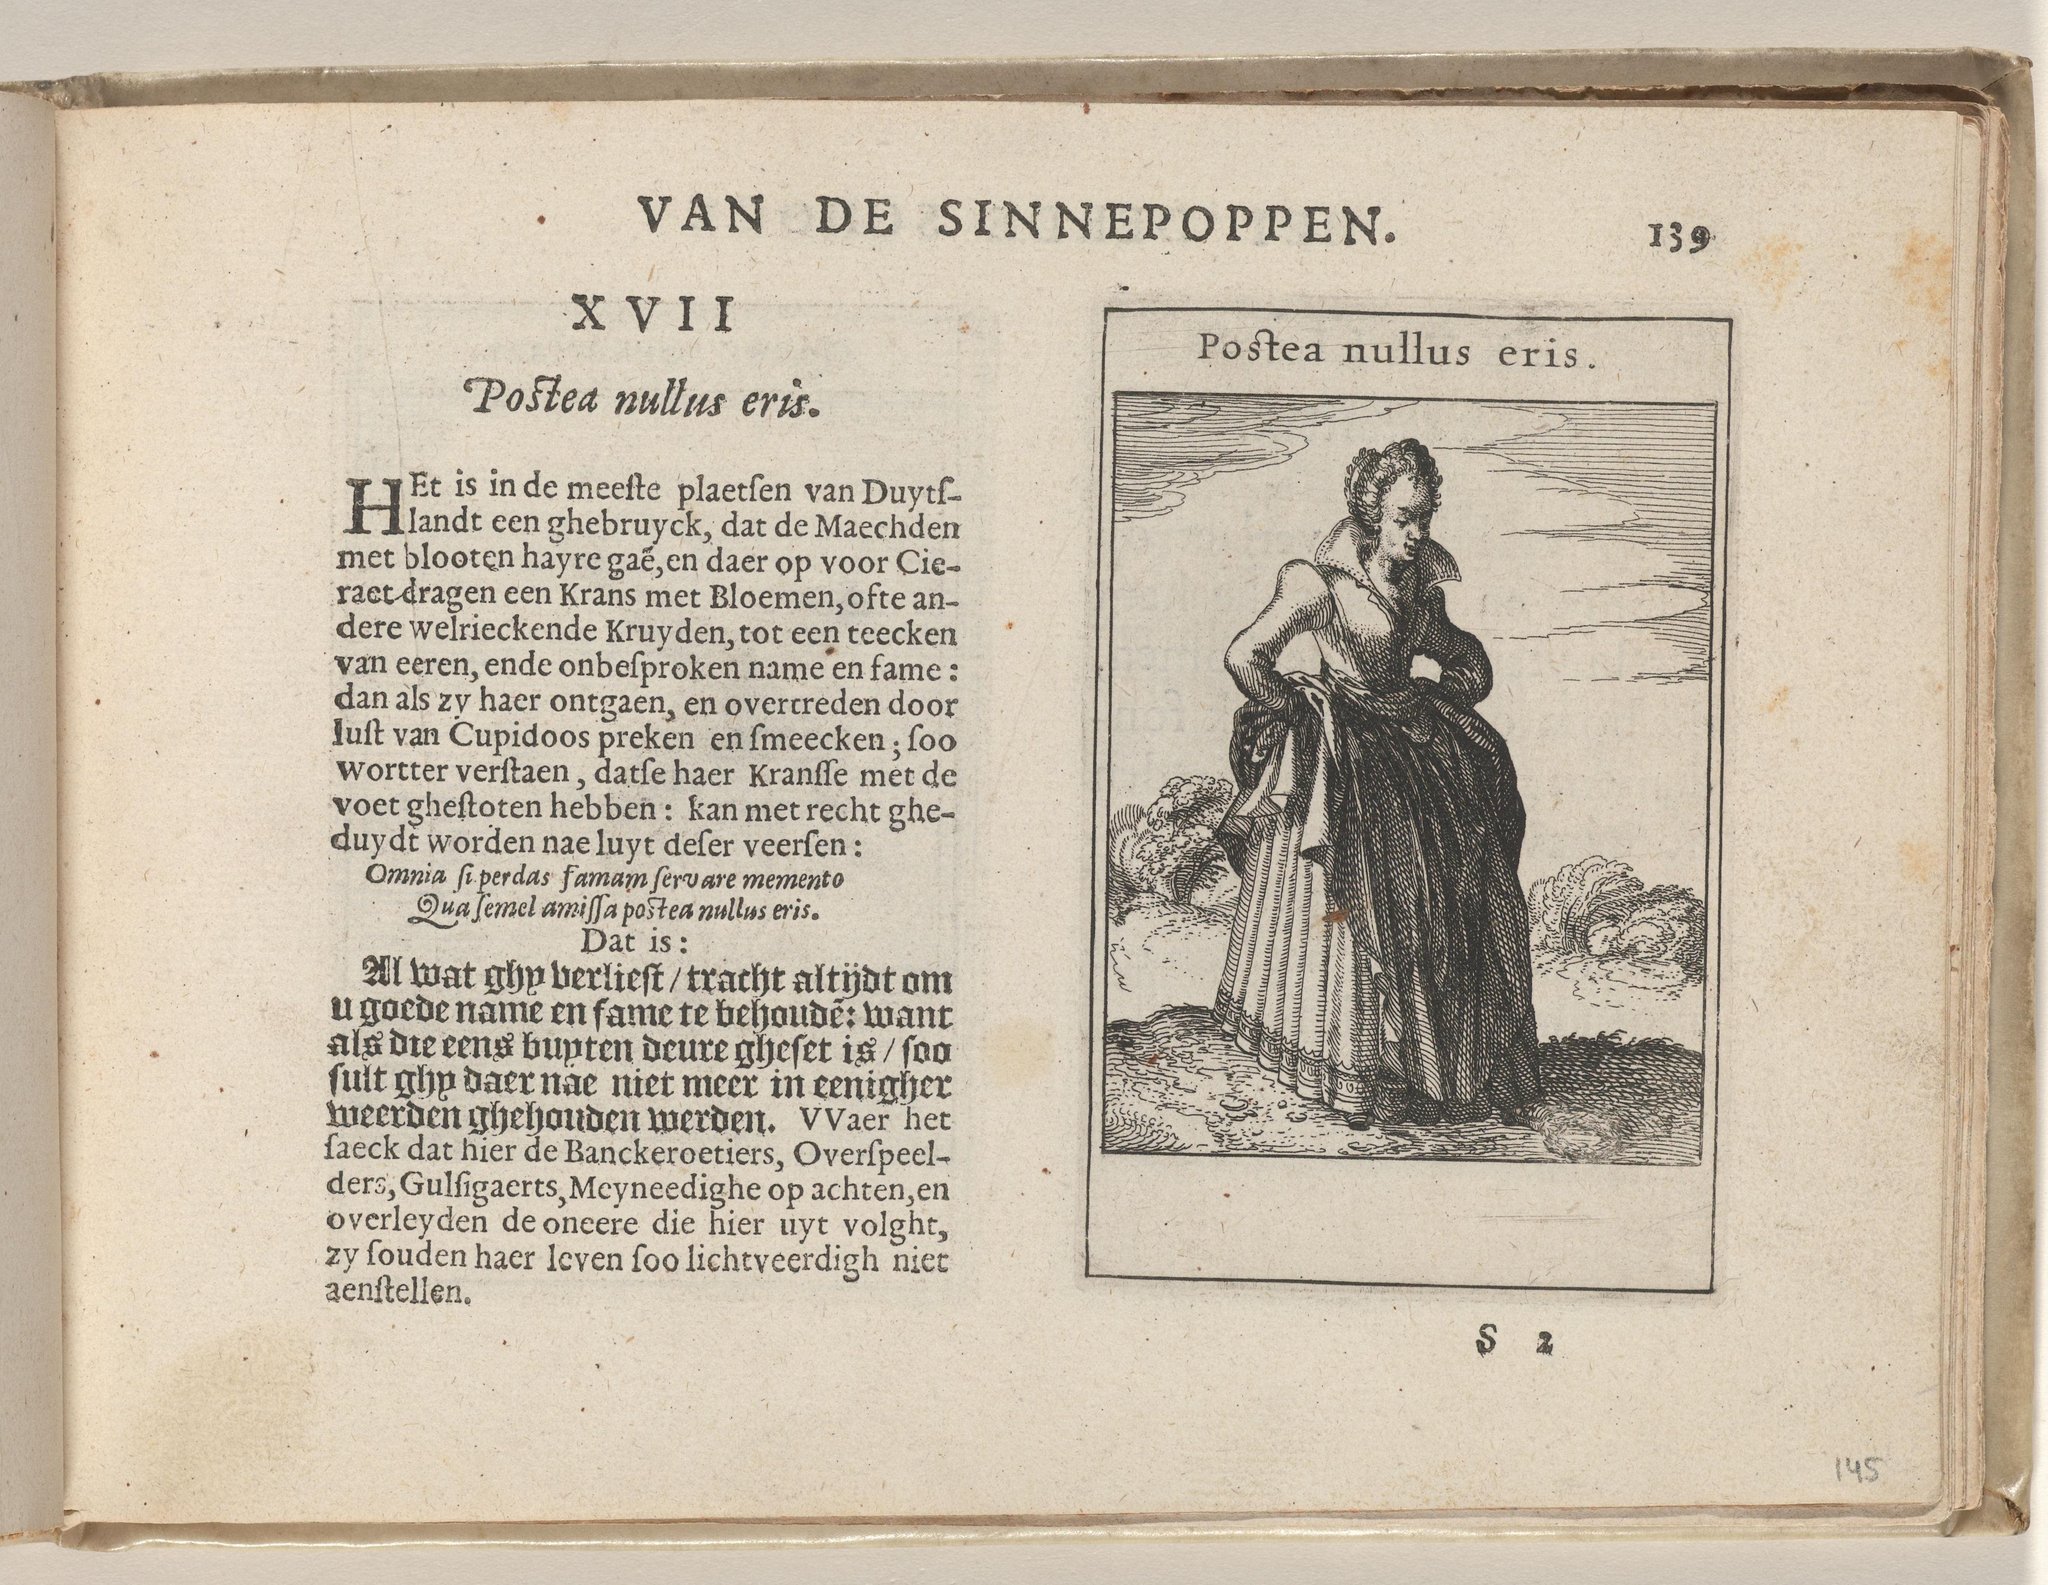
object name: album leaf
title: XVII Postea nullus eris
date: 1614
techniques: engraving, printing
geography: amsterdam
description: XVII Postea nullus eris. Derde schok. Onderdeel van 'Sinnepoppen', R. Visscher, 1614.